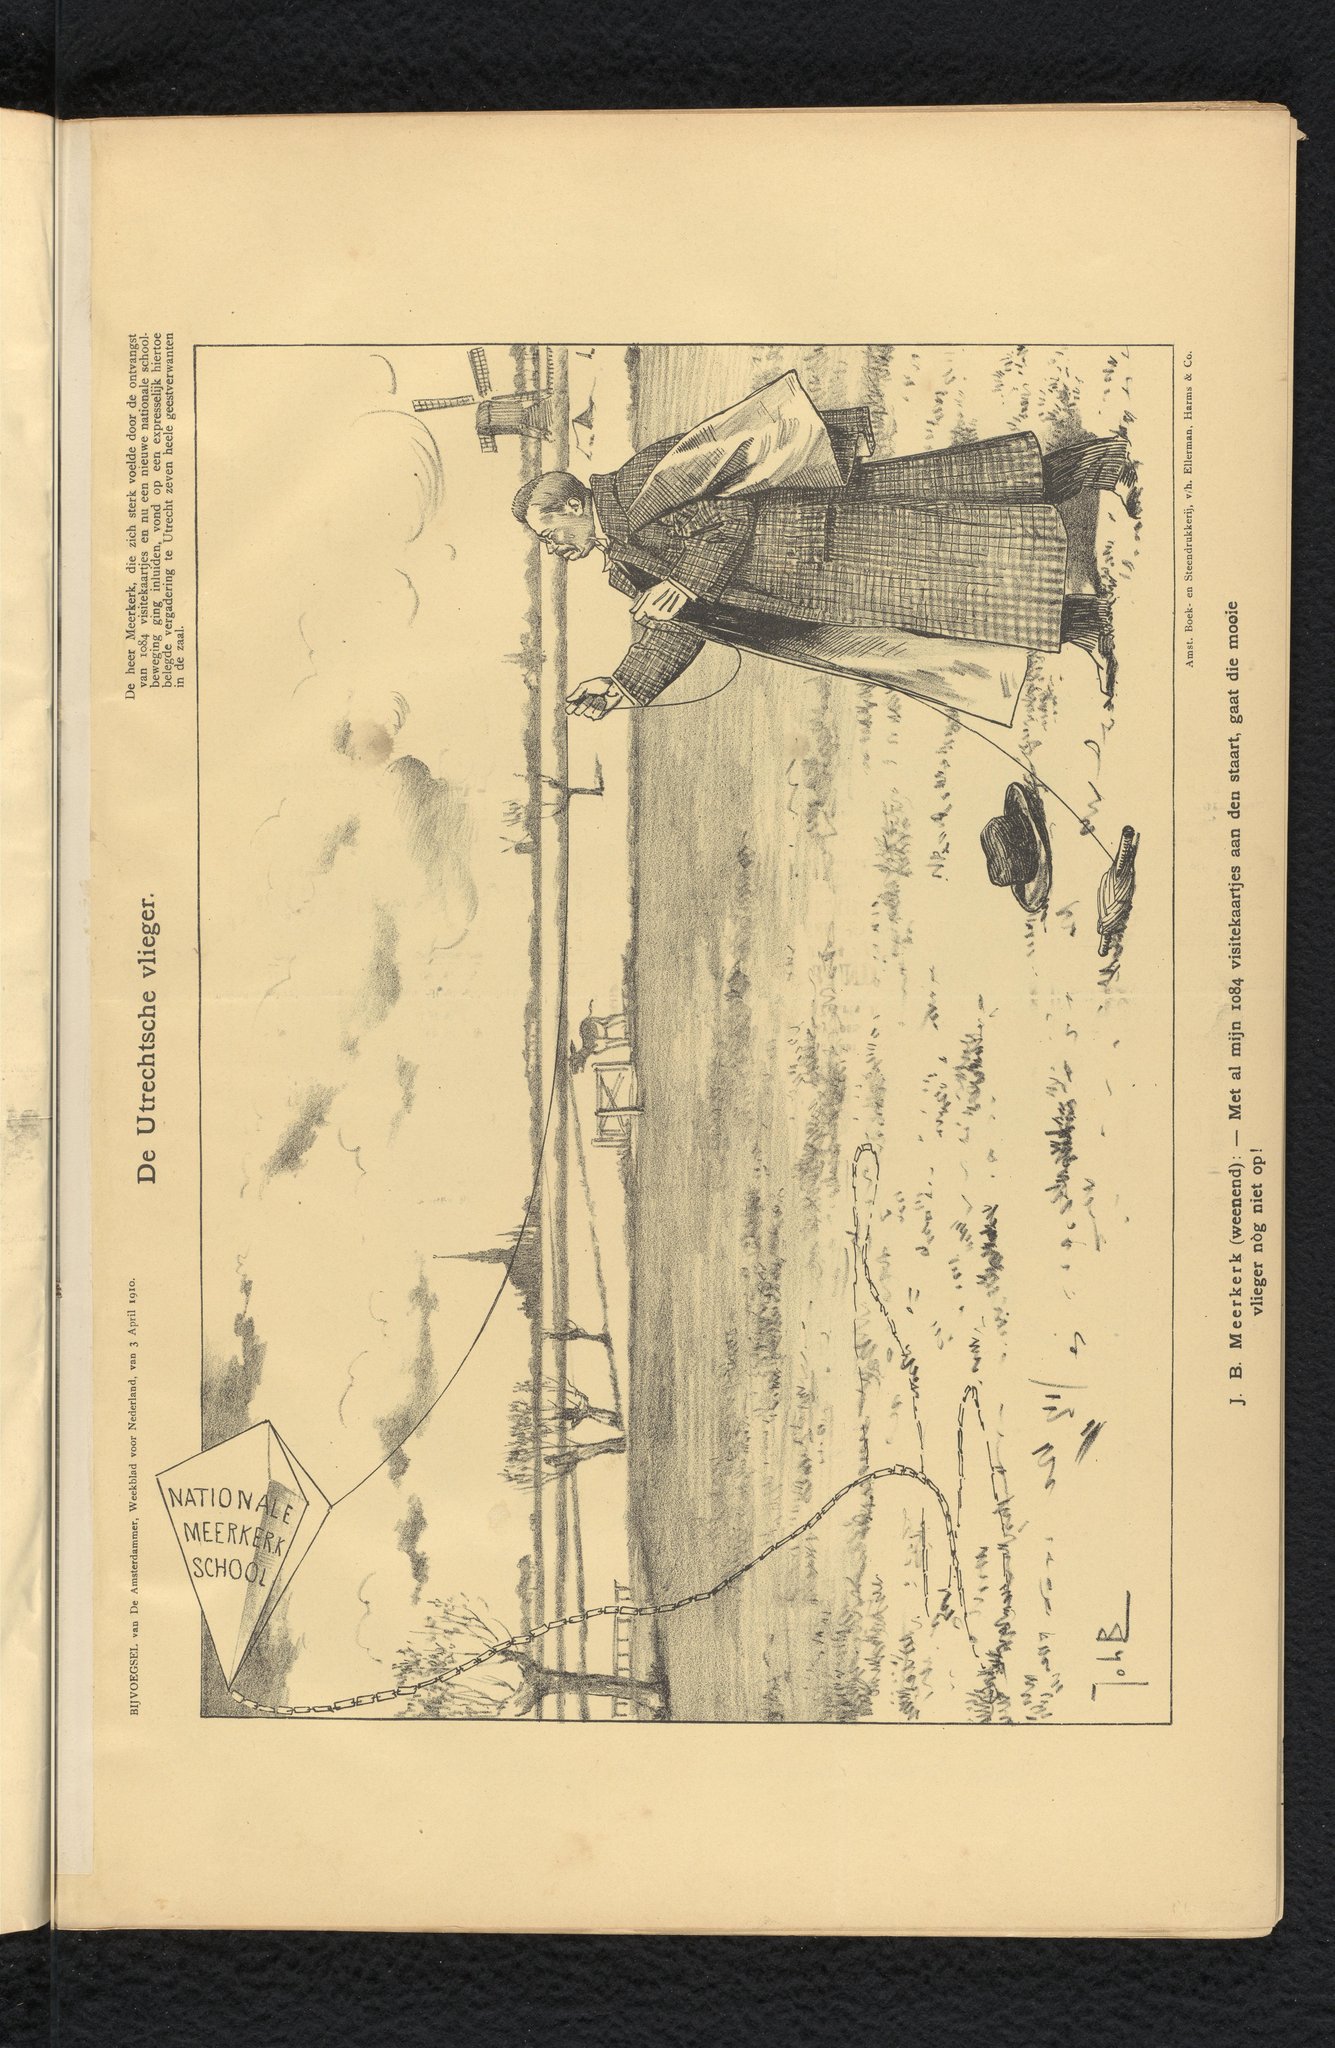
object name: cartoon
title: De Utrechtsche vlieger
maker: johan braakensiek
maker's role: draughtsman, print maker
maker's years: 1858-1940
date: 1910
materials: paper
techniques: lithograph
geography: netherlands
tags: (flying a) kite, political caricatures and satires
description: De vlieger van de 'Nationale Meerkerk School' opgelaten door Jacob Bartus Meerkerk gaat niet op.